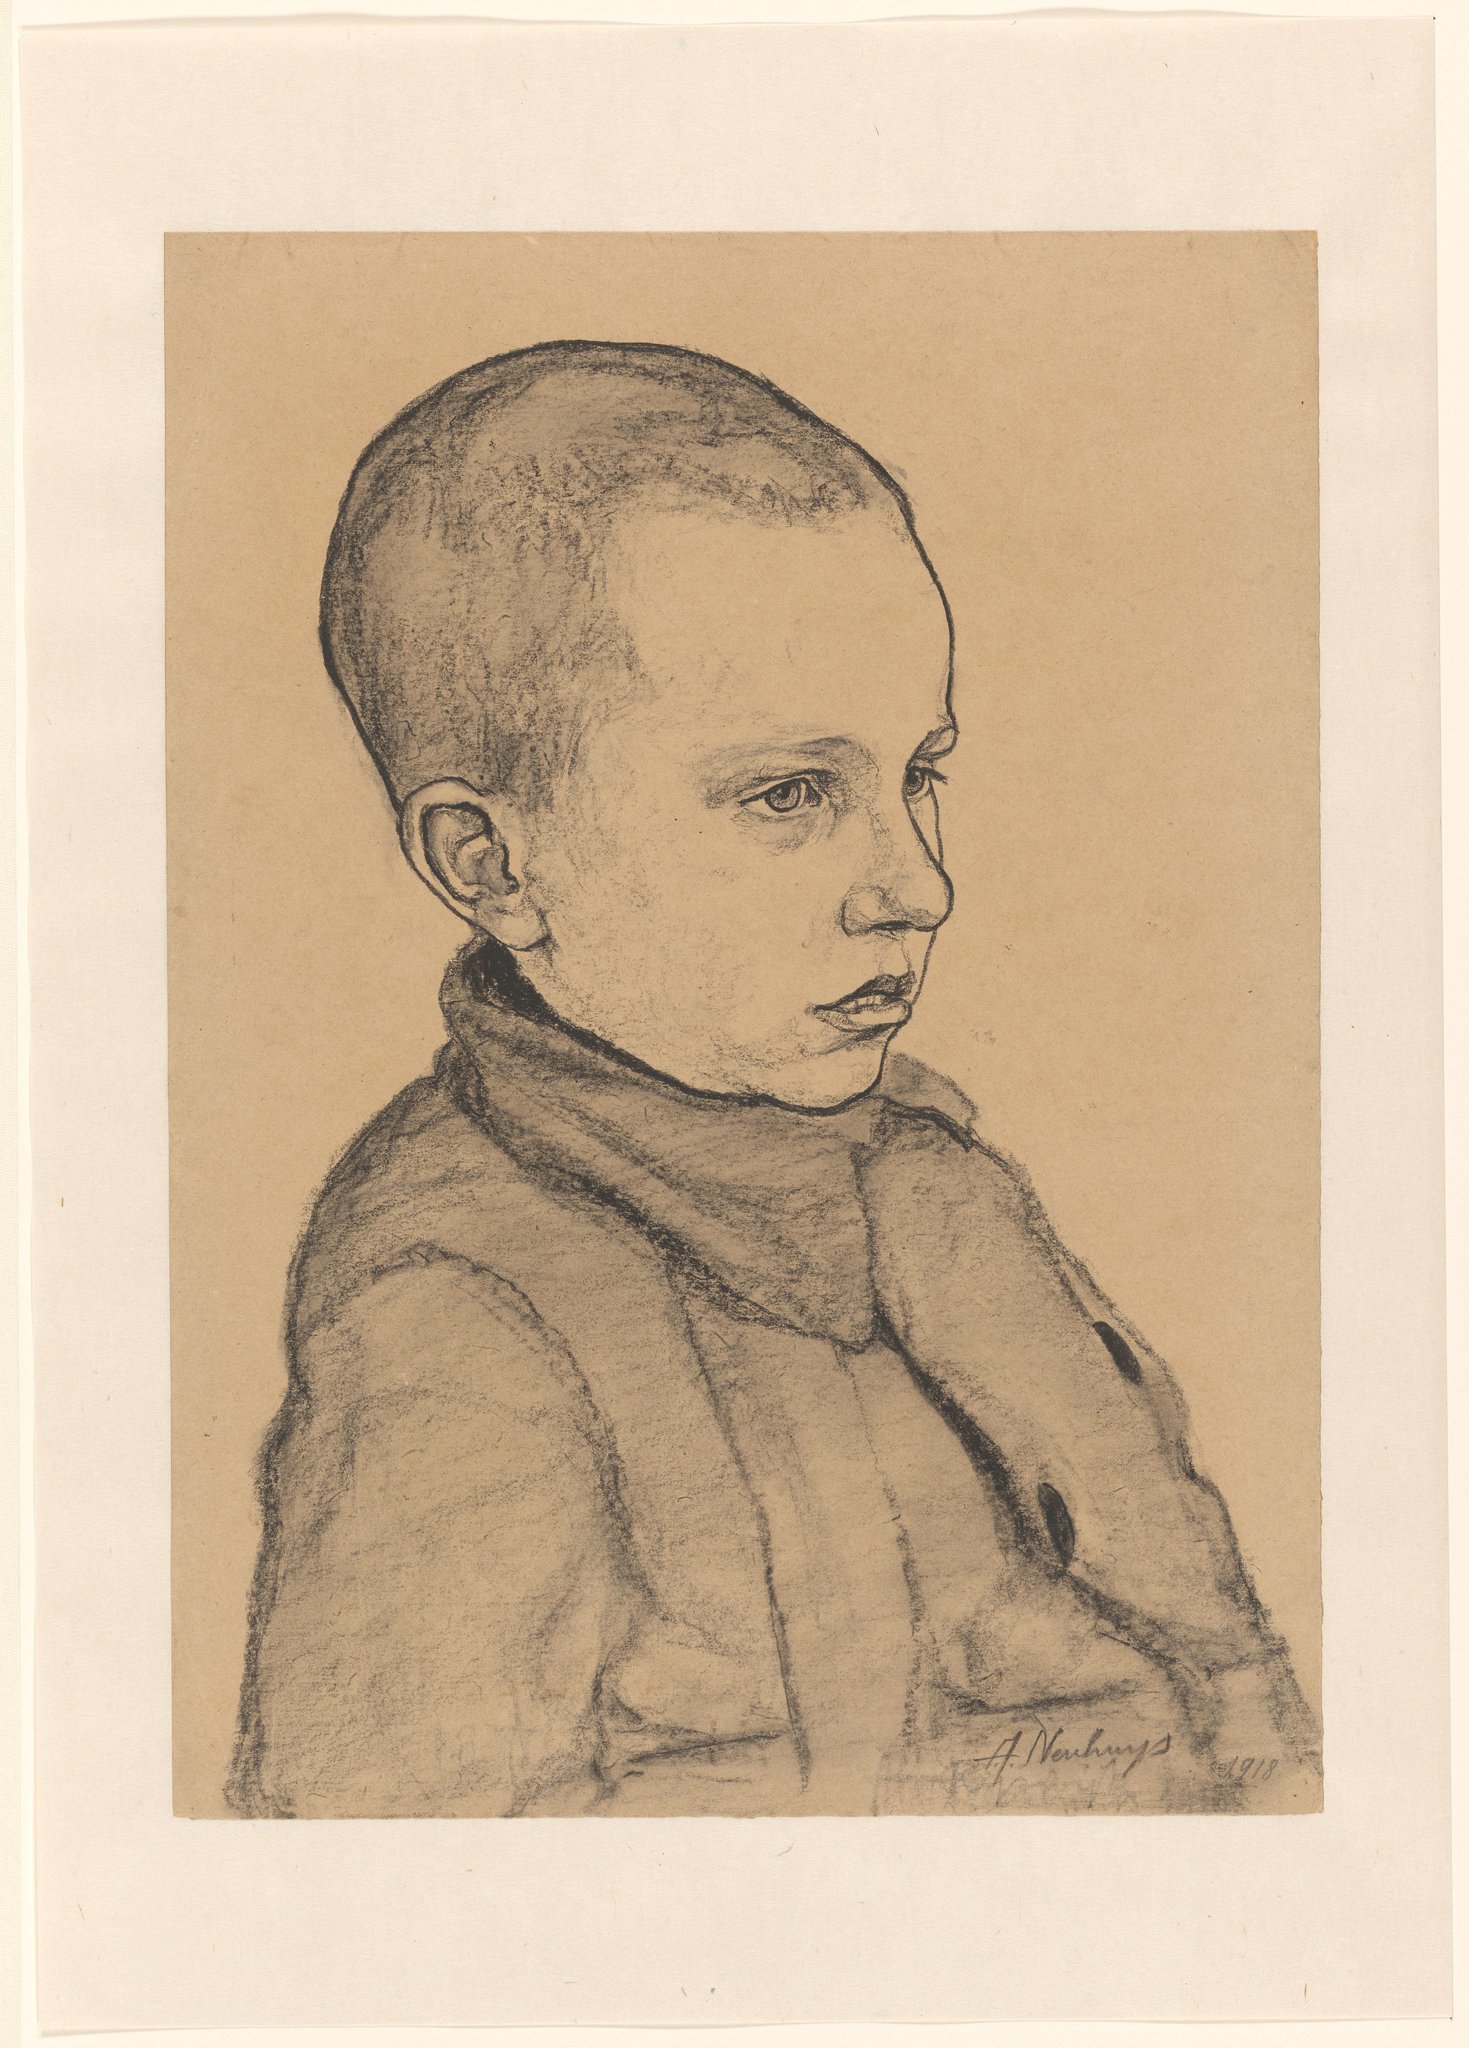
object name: drawing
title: Portret van een jongen, naar rechts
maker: albert neuhuys (1844-1914)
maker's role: draughtsman, painter, print maker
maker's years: 1844-1914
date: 1918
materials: charcoal, paper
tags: anonymous historical person portrayed alone